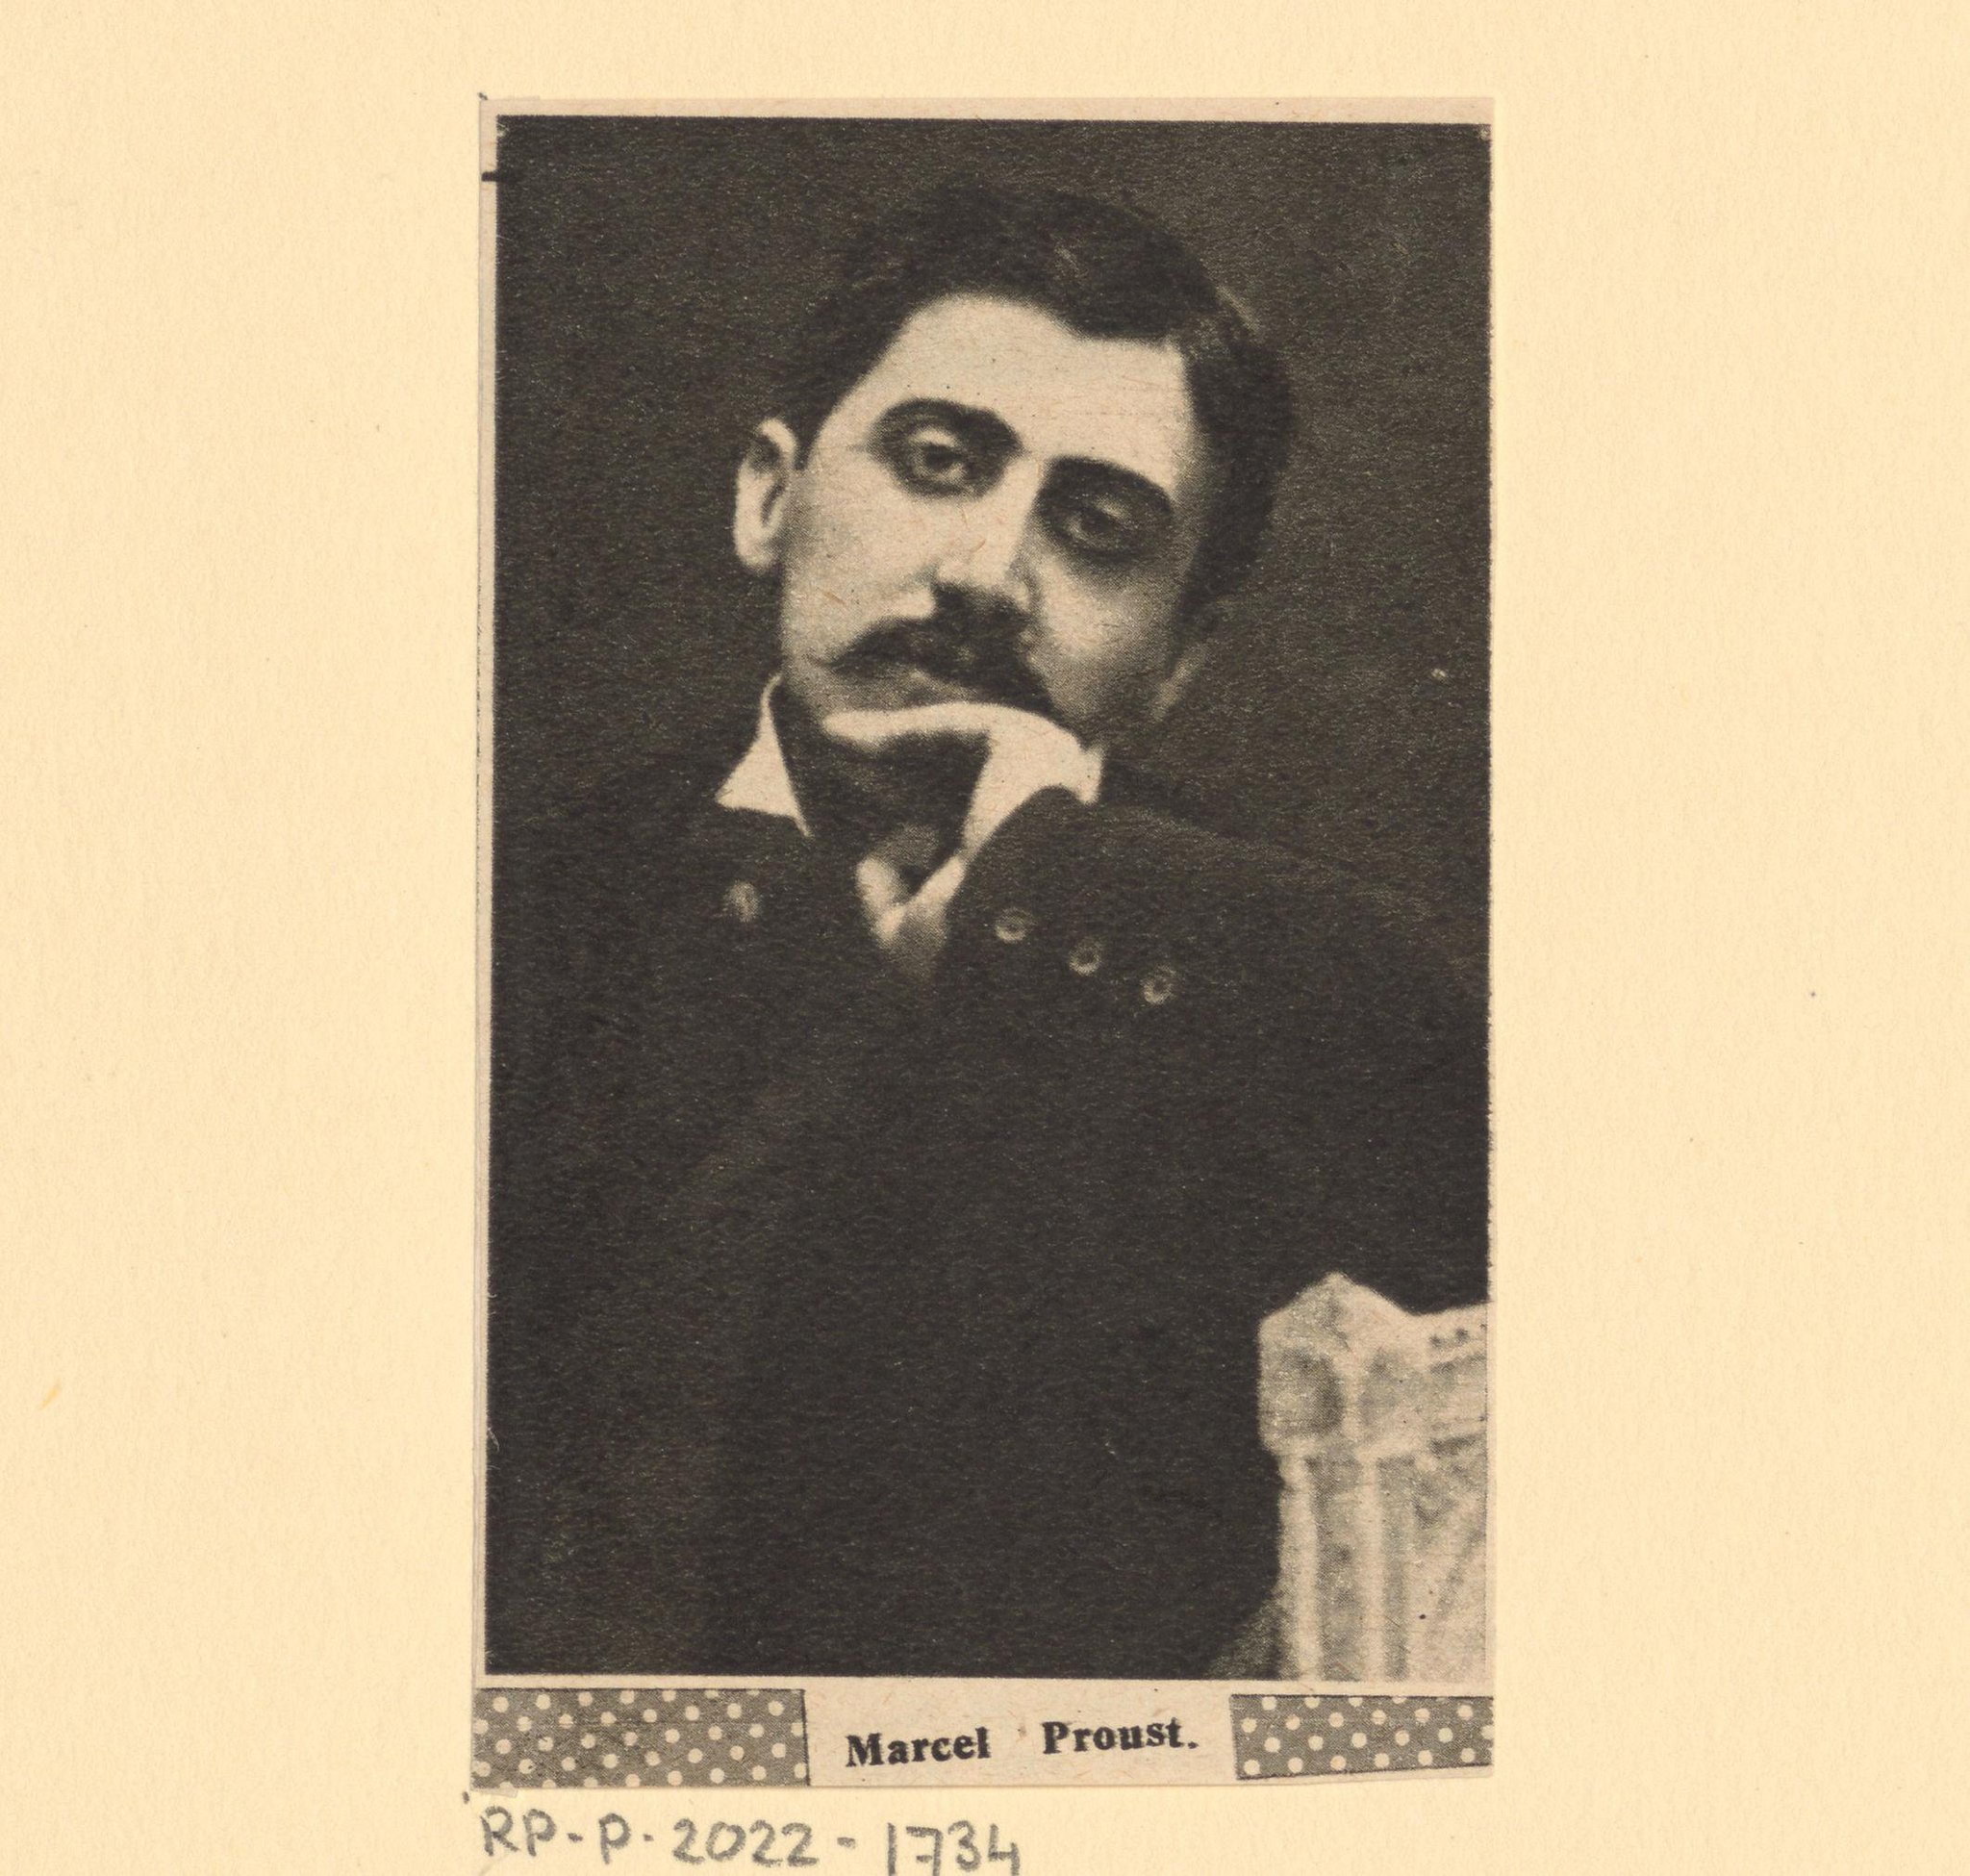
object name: photomechanical print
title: Portret van Marcel Proust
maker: Anonymous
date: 1896-1930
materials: paper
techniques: photograph, letterpress printing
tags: paris, historical persons, portrait of a writer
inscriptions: stamp: ‘JVB’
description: Fotomechanische afdruk uit een onbekende publicatie.